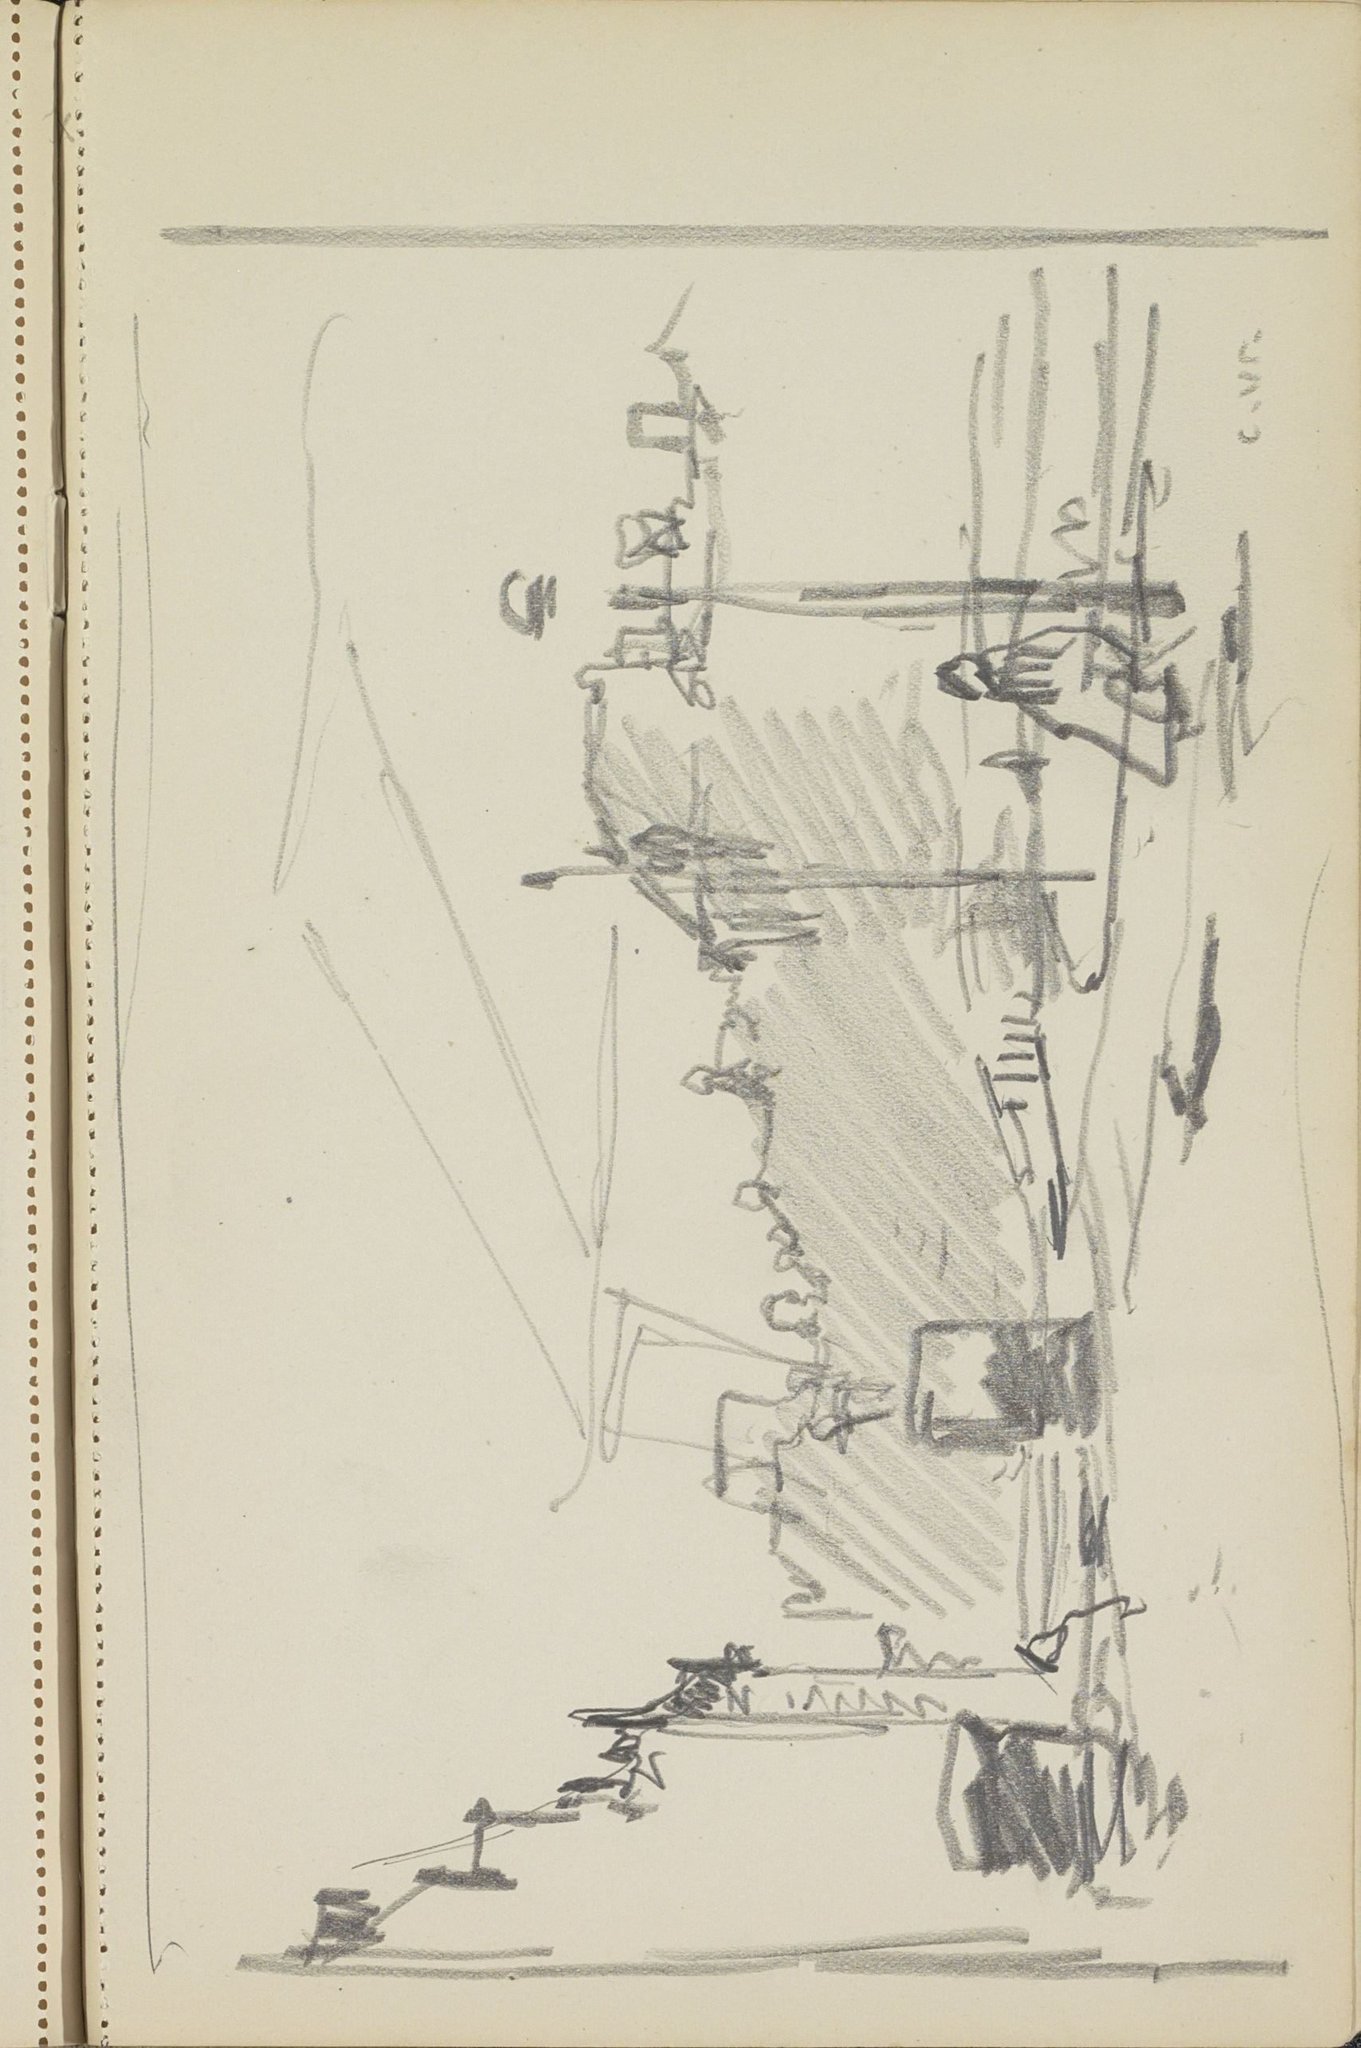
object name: sketchbook leaf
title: Straat met een trambaan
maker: cornelis vreedenburgh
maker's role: draughtsman, print maker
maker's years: 1880-1946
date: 1890-1946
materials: paper, pencil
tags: tramway, tram, street (+ city(-scape) with figures, staffage)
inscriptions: signature: ‘c. vr.’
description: Blad 49 recto uit een schetsboek met 56 bladen.